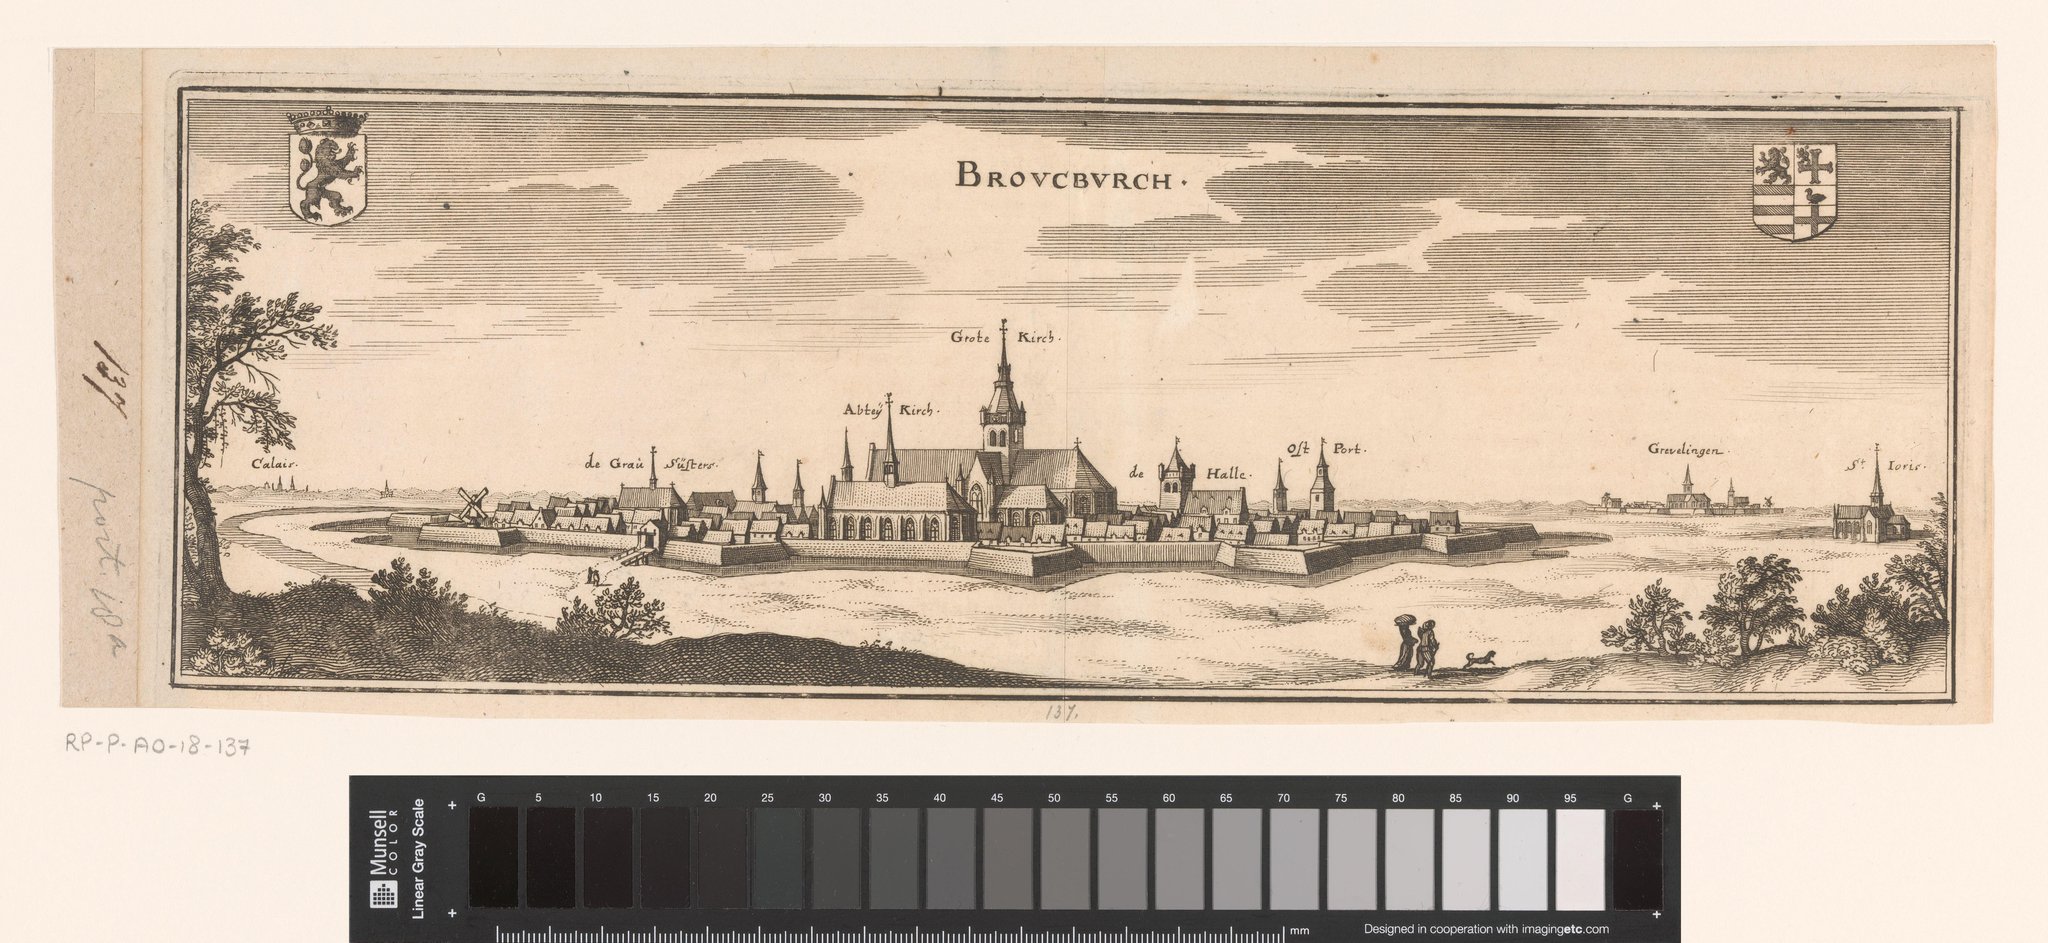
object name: print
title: Gezicht op Bourbourg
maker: caspar merian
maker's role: print maker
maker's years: 1627-1689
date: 1654-1700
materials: paper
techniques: engraving, etching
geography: frankfurt am main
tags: church (exterior), coat of arms (as symbol of the state, etc.) (+ province; provincial), prospect of city, town panorama, silhouette of city, armorial bearing, heraldry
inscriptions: collector's mark: Lugt 2228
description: Prent gebruikt in: Zeiller, Martin. M.Z. Topographia Circuli Burgundici Oder Beschreibung une Eigentliche Abbildung der Vornehmsten Örter in dem Hochlöblichen Burgund- un Niderlandischen Crayse. Frankfurt am Main: Caspar Merian, 1654. Of in: Zeiller, Martin. M. Z. Topographia Germaniae-Inferioris vel Circuli-Burgundici, das ist Beschreibung (…). Frankfurt am Main: Caspar Merian, 1659. Of in een van de twee latere uitgaven van deze publicatie die, hoewel het jaar 1659 erin staat vermeld als jaar van uitgave, zijn uitgegeven in respectievelijk ca. 1670 en ca. 1700.